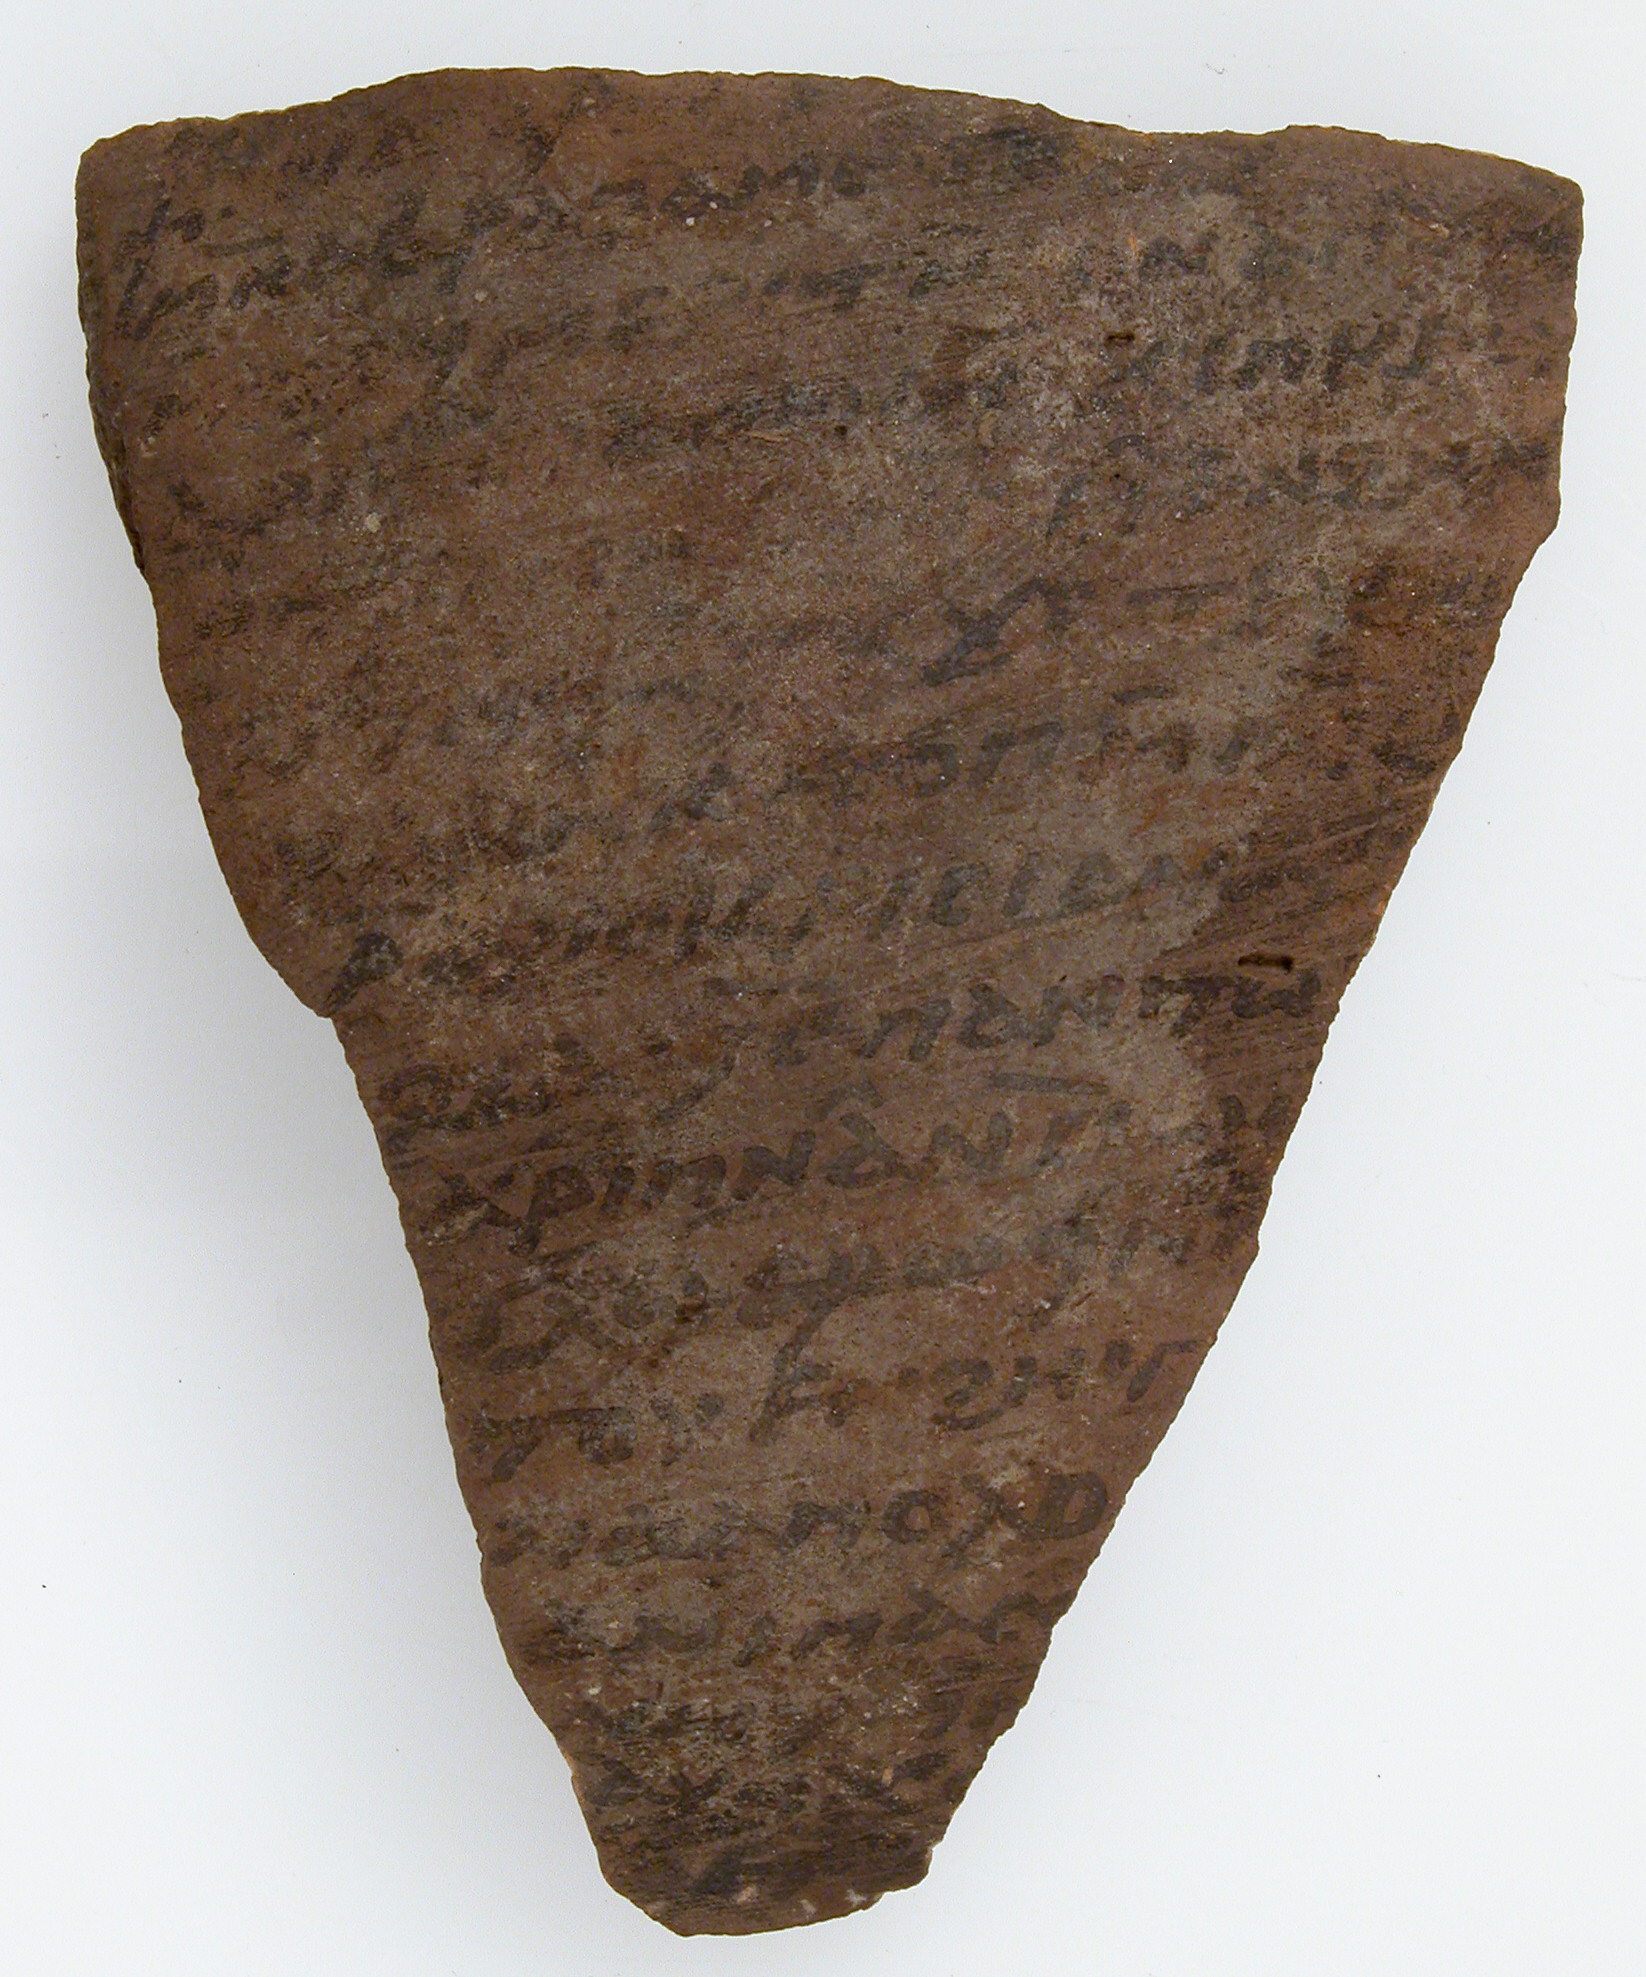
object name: ostrakon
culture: coptic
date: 601-700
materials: ink, pottery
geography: egypt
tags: documents